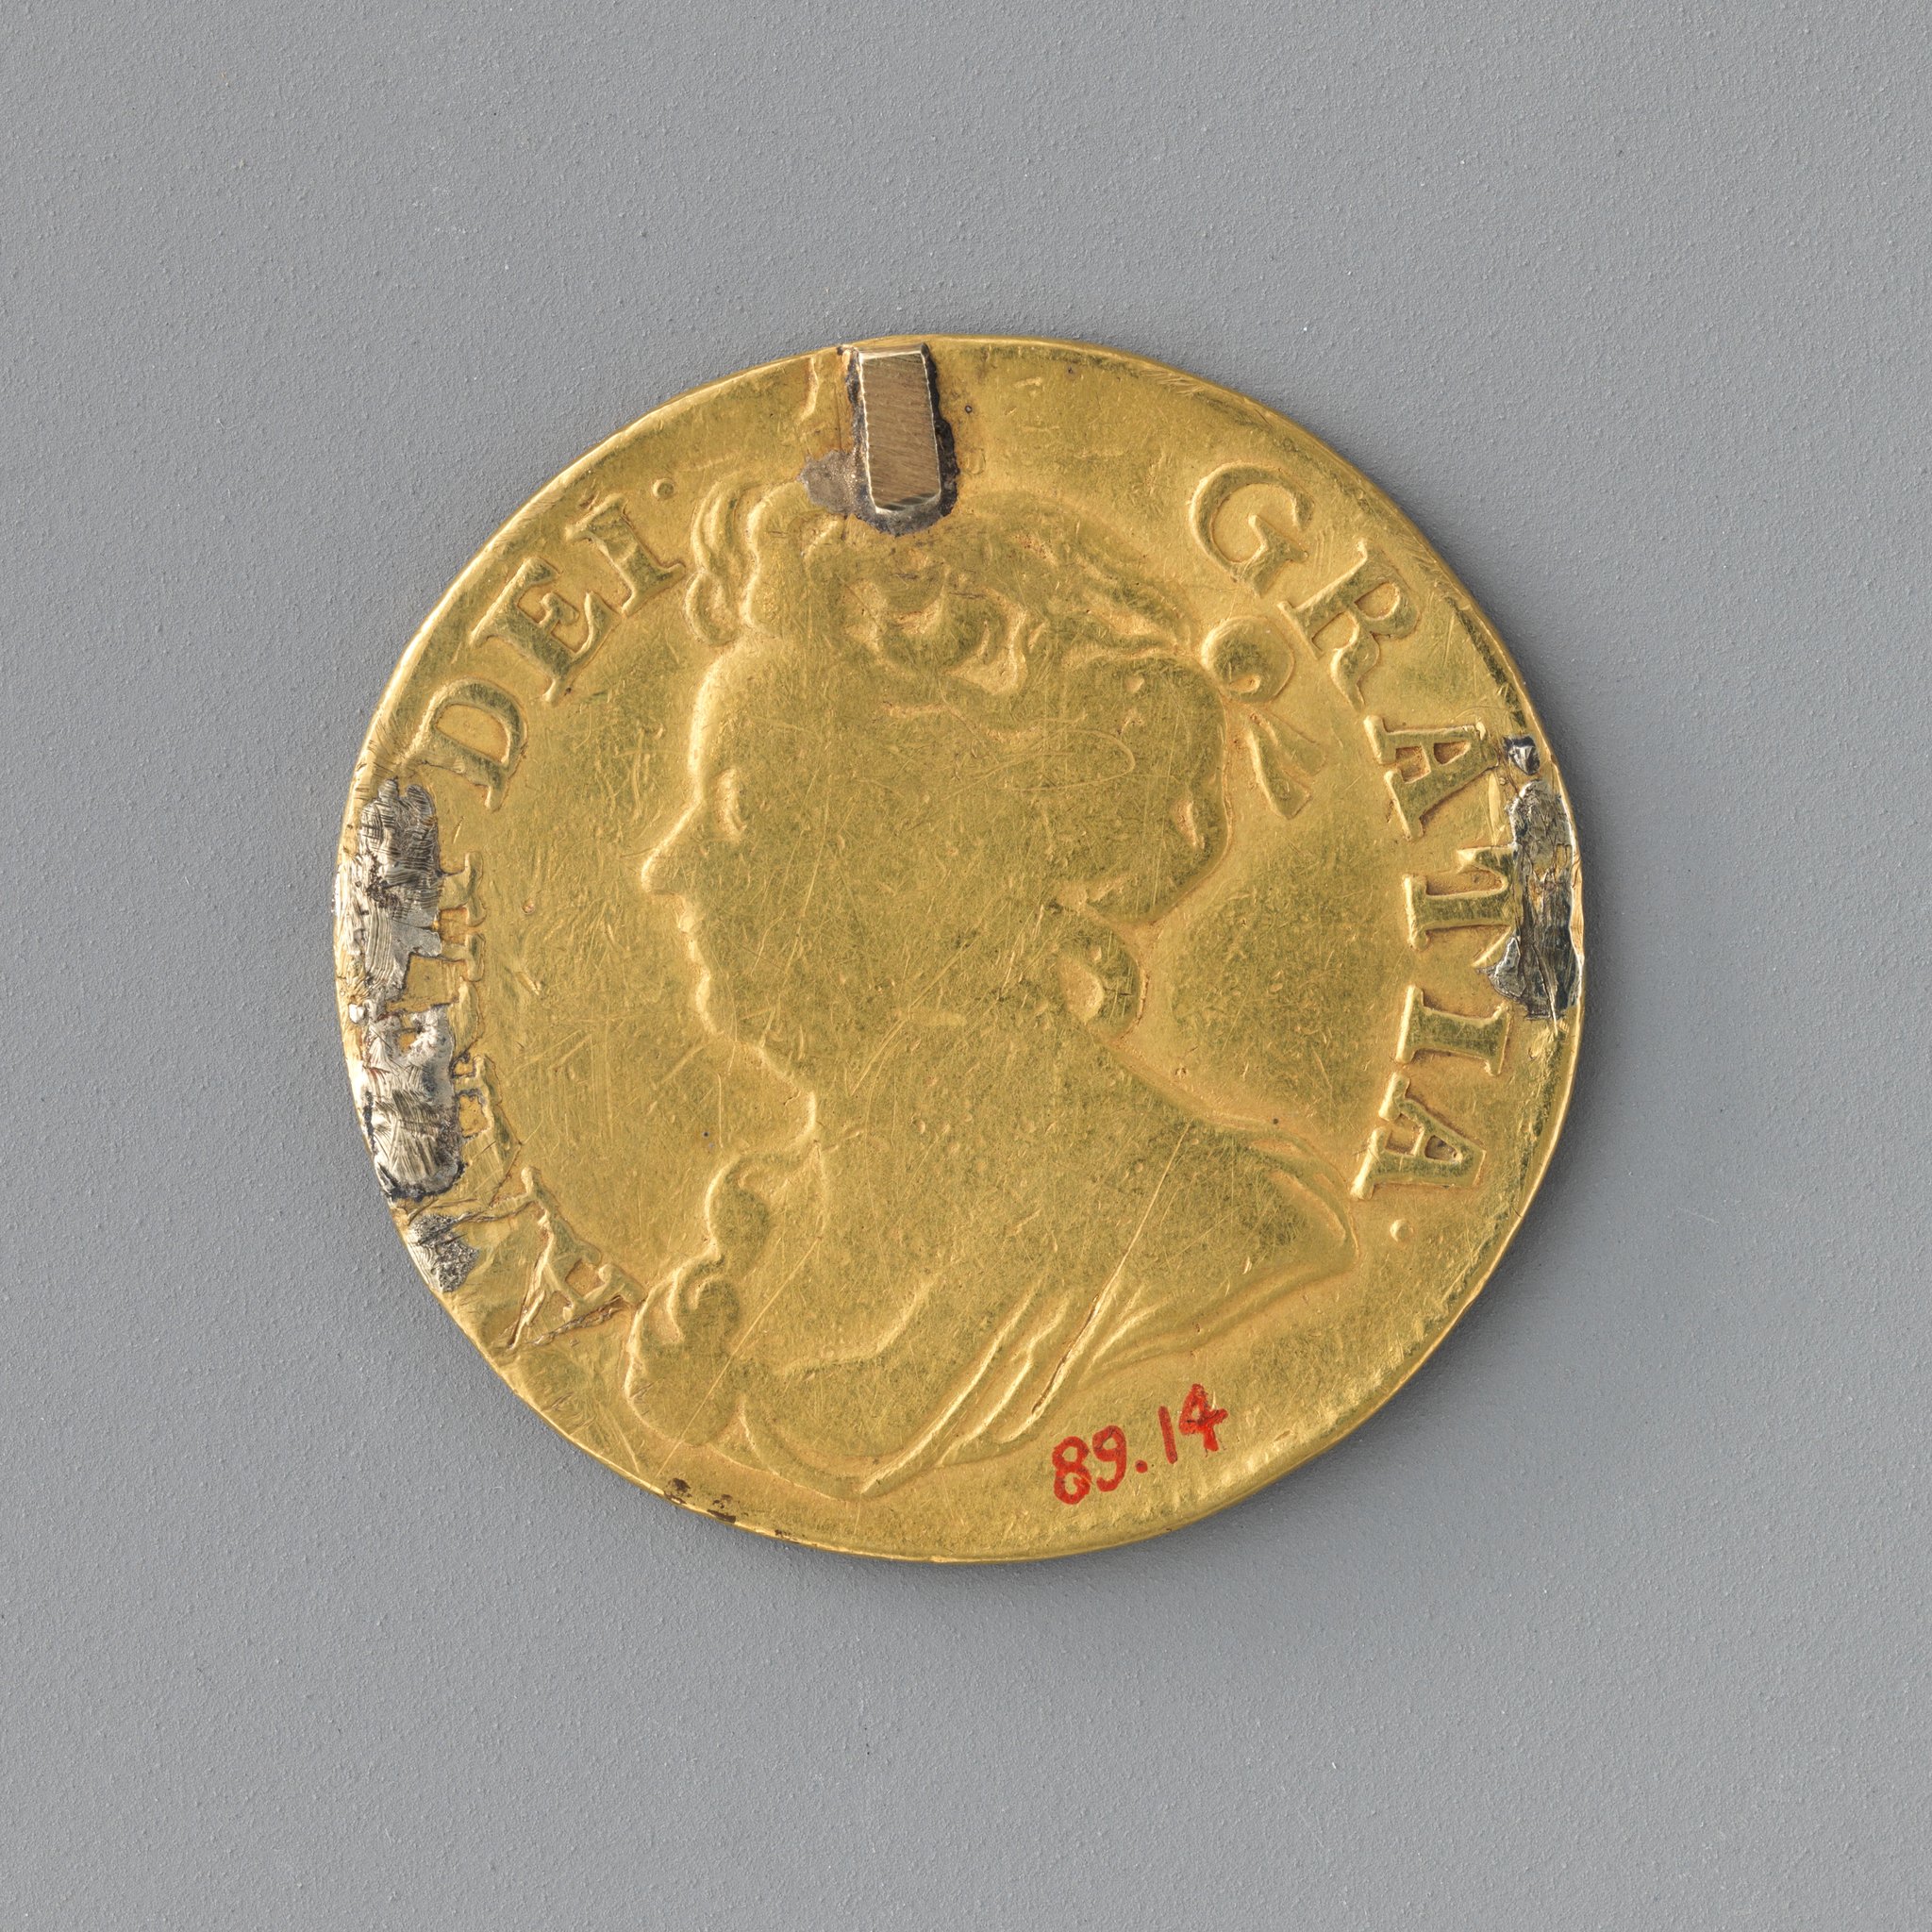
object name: guinea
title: Queen Anne (r. 1702–14) guinea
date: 1710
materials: gold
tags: queens,profiles,coins